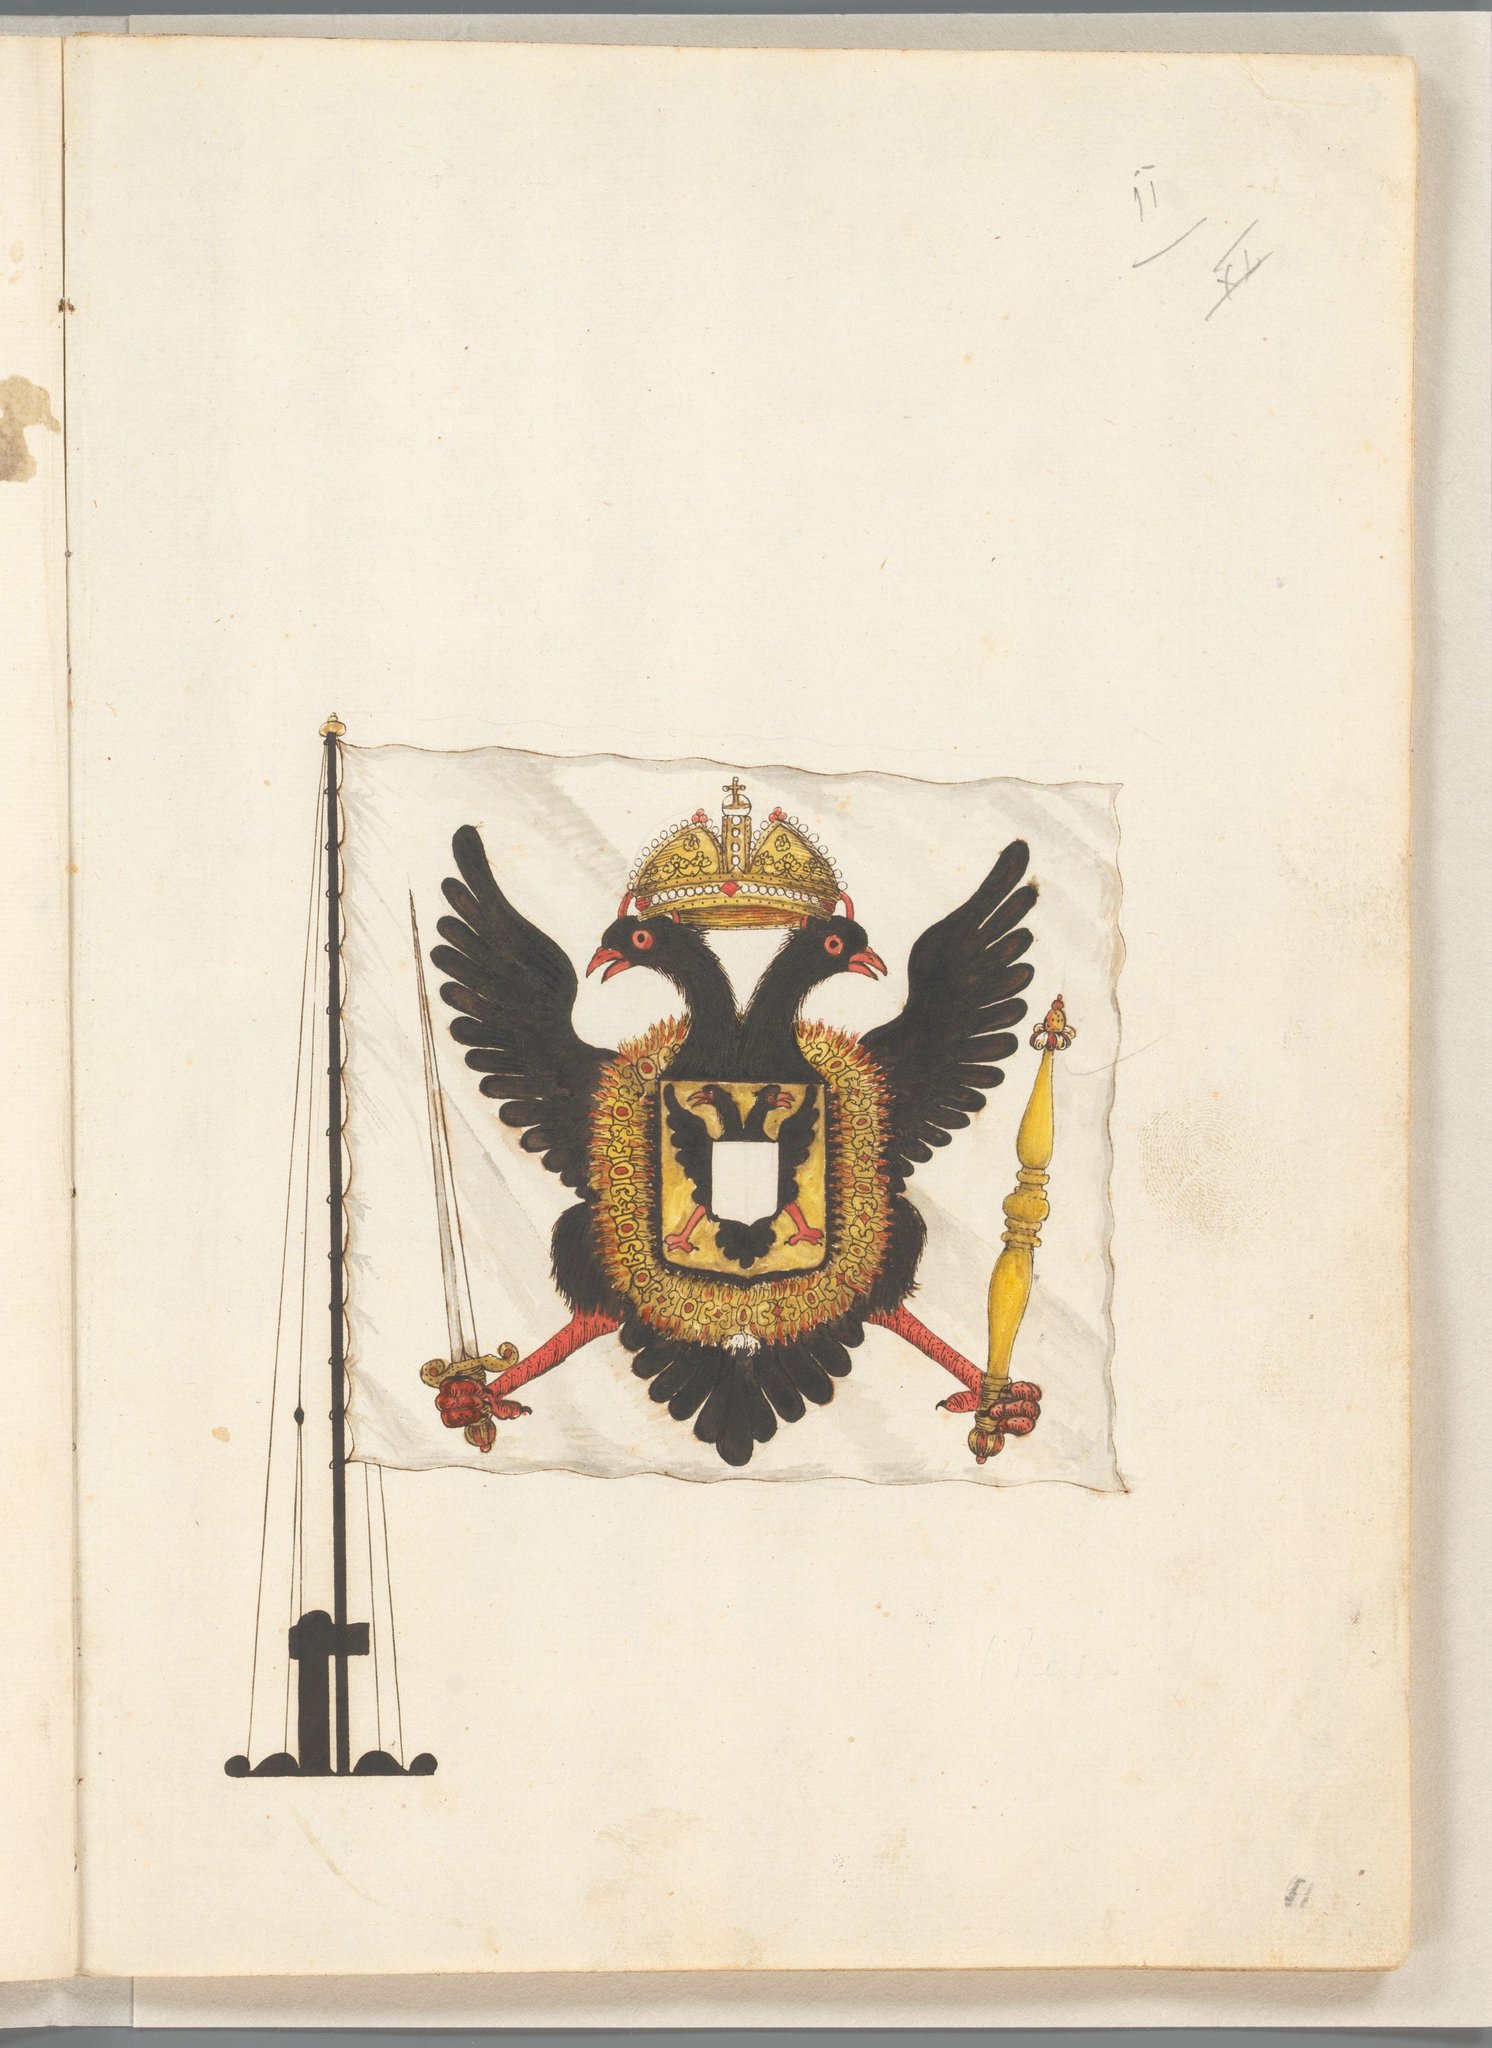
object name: drawing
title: Vlag van het Heilige Roomse (Duitse) Rijk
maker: Anonymous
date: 1667-1670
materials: ink, paper, watercolor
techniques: brush, pen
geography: france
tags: flag, colours (as symbol of the state, etc.), holy roman empire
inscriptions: number: ‘11 / XI / 11’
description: Vlag van het Heilige Roomse (Duitse) Rijk met op een wit veld een dubbele zwarte adelaar onder een keizerskroon en met in de poten een zwaard en scepter, om de hals het ordeteken van het Gulden Vlies en op de borst een wapenschild met wederom het wapen van het Heilige Roomse (Duitse) Rijk met in het midden op dit wapenschild een blanco wapenschildje waar het wapen van de regerende koning of keizer ingetekend kon worden. Vlag op vlaggensteng en mastvoet. Afgebeeld op folio 6r. Onderdeel van een vlaggenboek met vlaggen uit Europa, Noord-Afrika, Nabije en Verre Oosten.